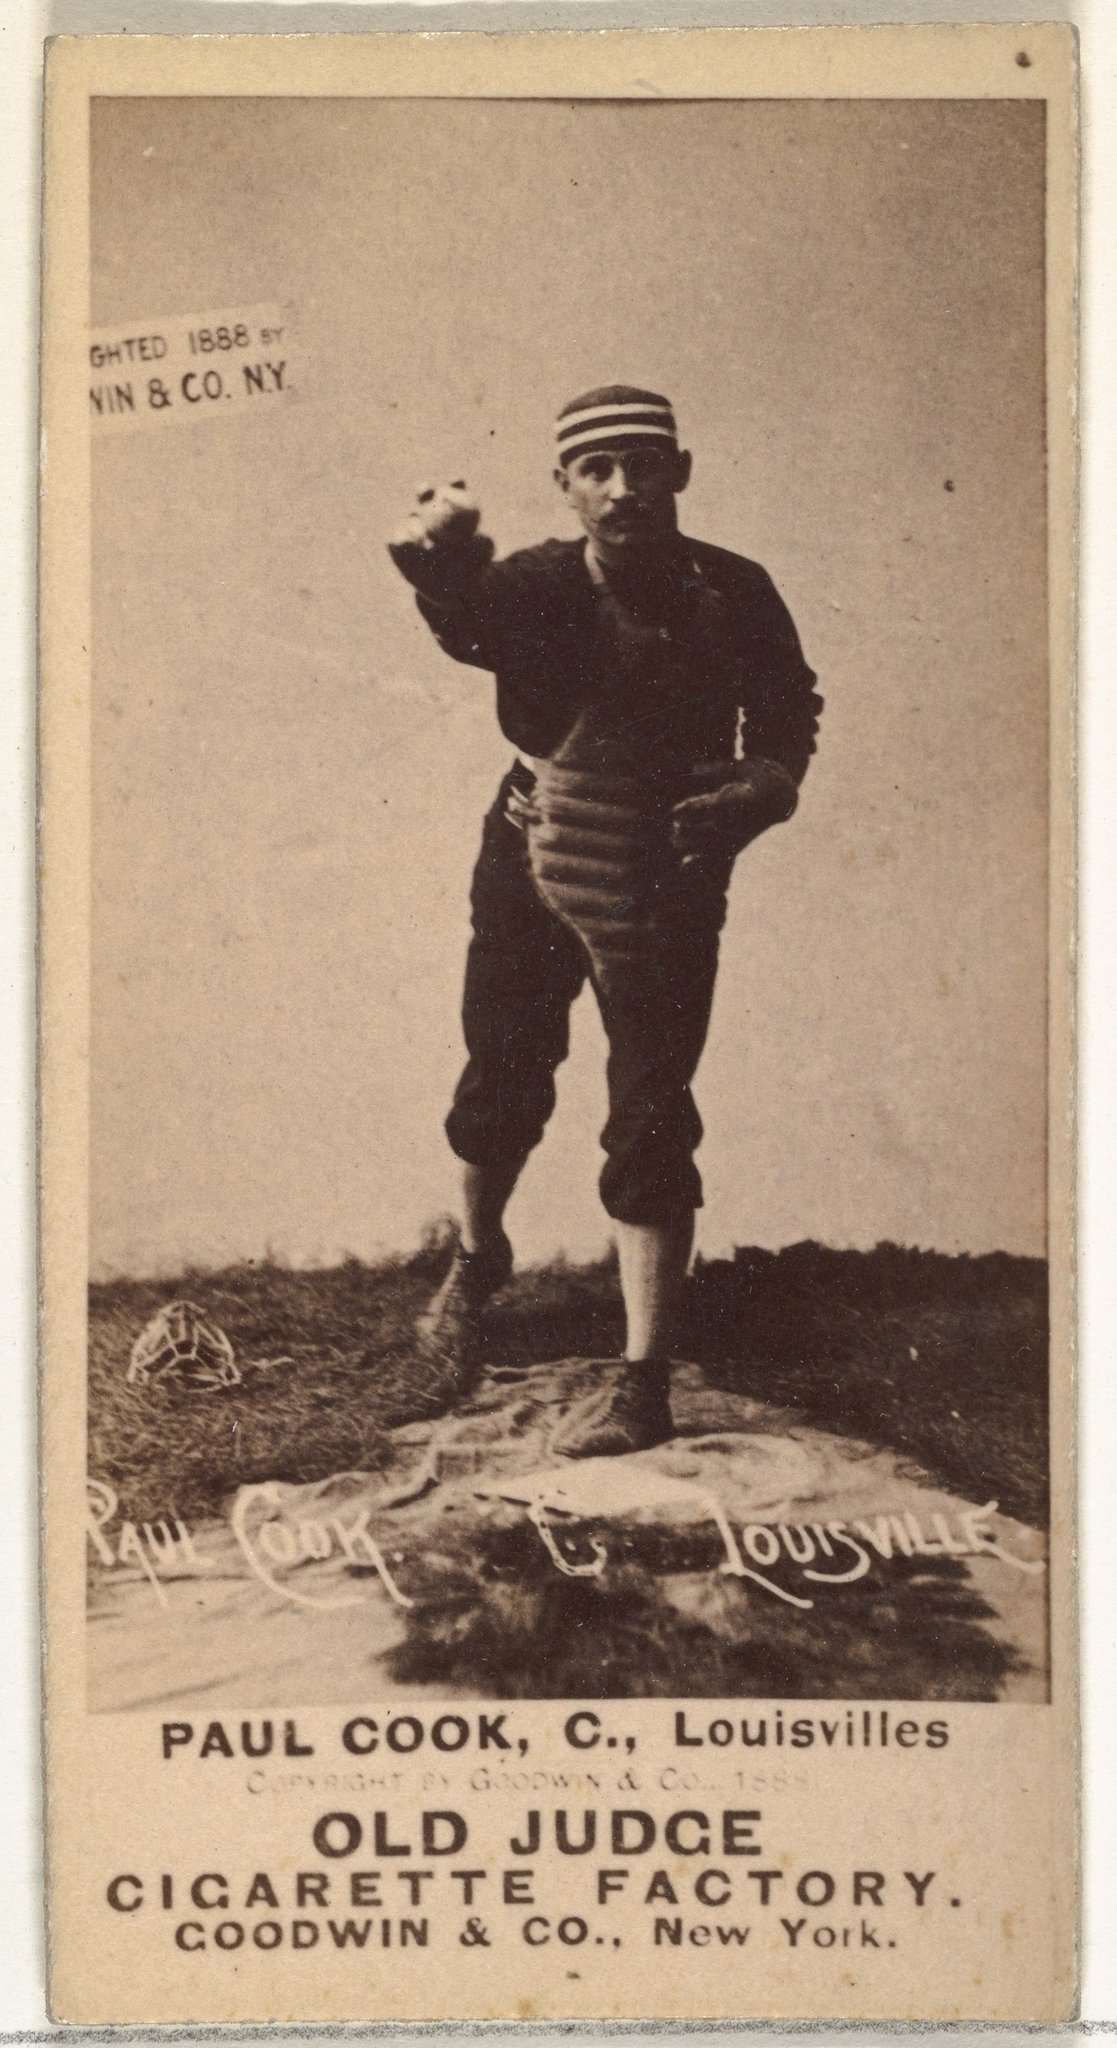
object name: baseball card, photograph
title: Paul Cook, Catcher, Louisville Colonels, from the Old Judge series (N172) for Old Judge Cigarettes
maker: goodwin & company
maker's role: publisher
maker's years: 1850-1950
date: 1888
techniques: albumen silver print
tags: men,portraits,baseball,athletes